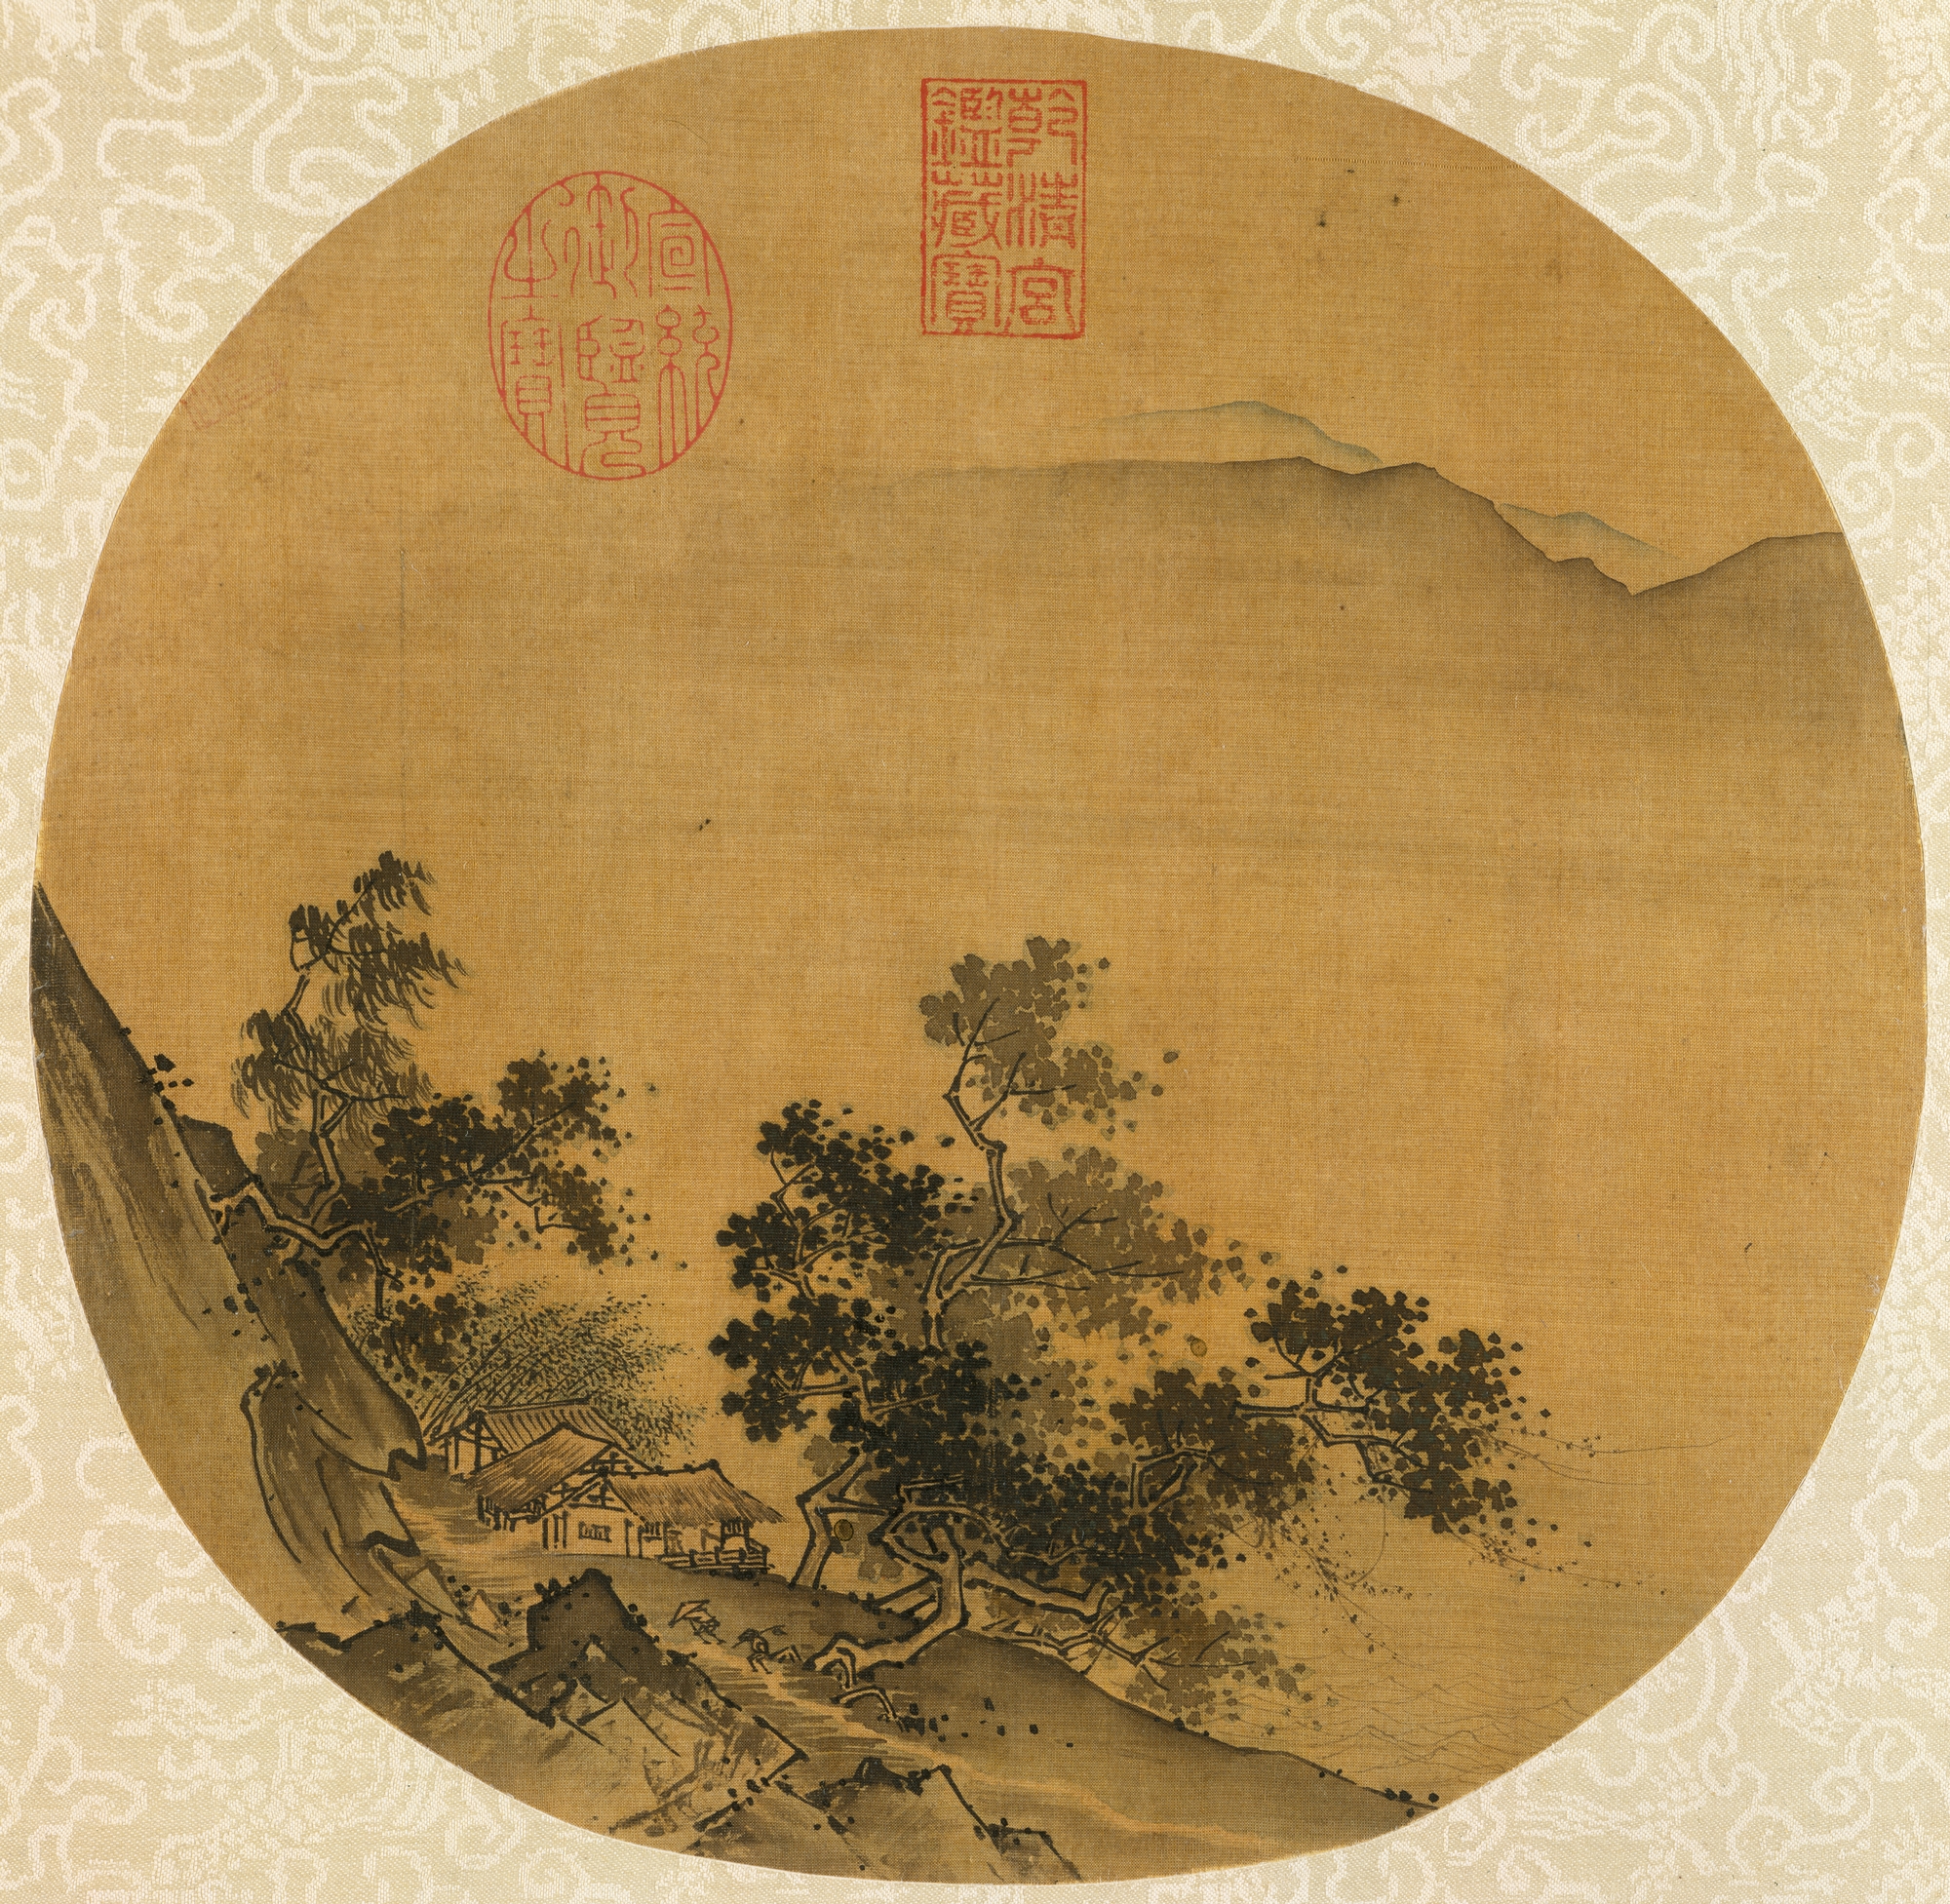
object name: fan mounted a an album leaf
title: Returning Home in a Driving Rain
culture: chinese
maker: xia gui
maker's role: artist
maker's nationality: chinese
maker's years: 1195-1230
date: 1201-1233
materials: ink, silk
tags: landscapes,trees